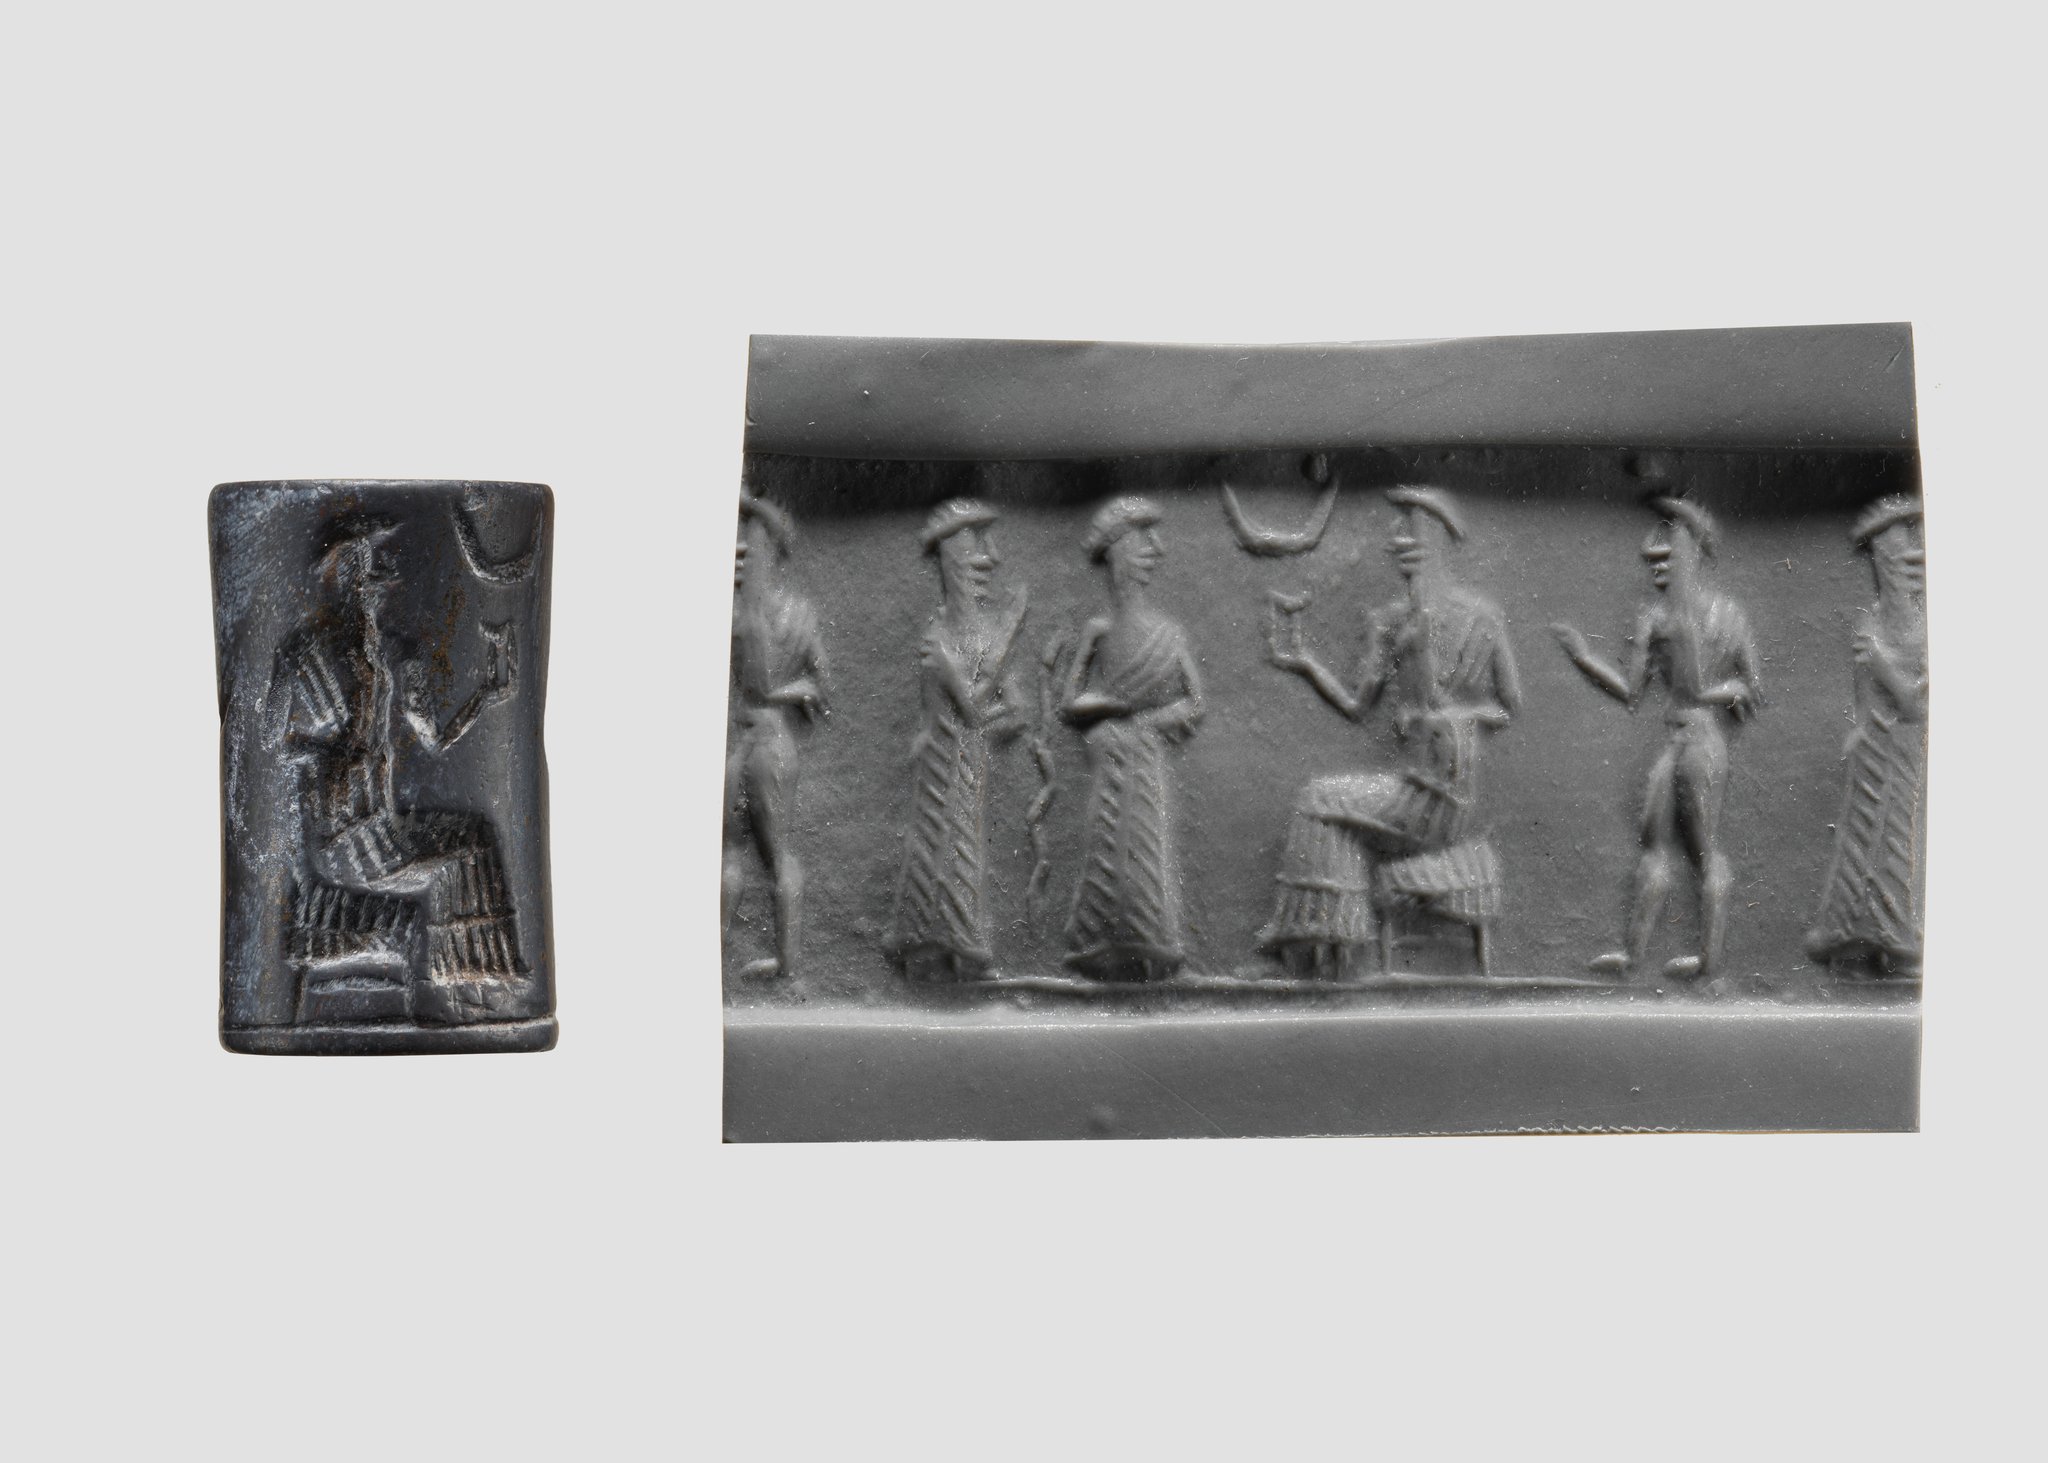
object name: cylinder seal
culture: babylonian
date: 2000-1668 BCE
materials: mineral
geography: mesopotamia